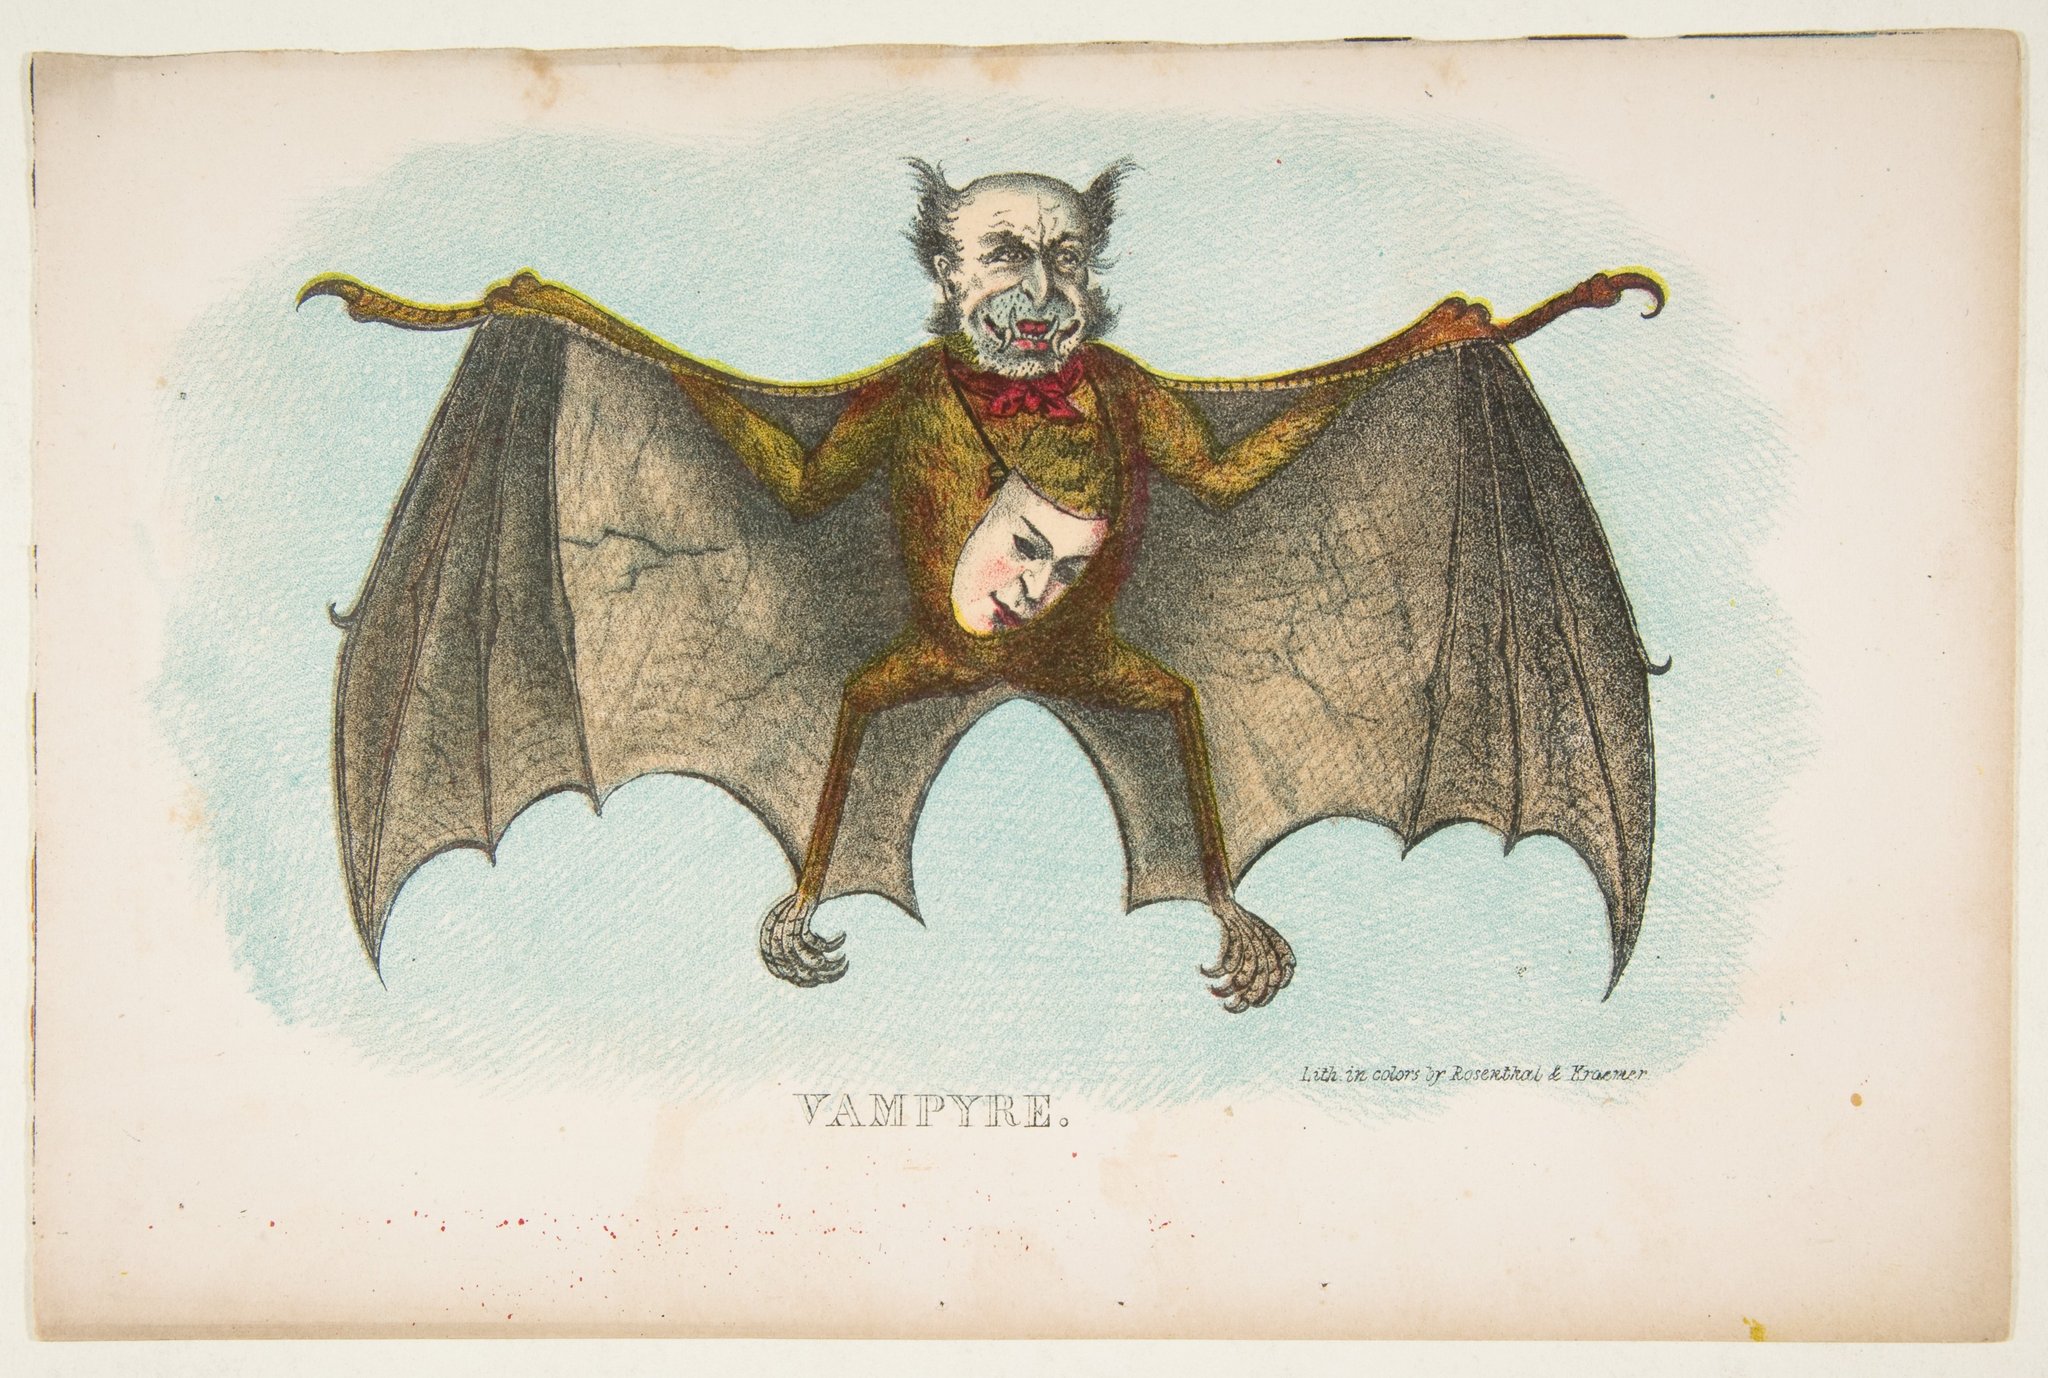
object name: print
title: Vampyr, from "The Comic Natural History of the Human Race"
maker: henry louis stephens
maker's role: artist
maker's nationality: american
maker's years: 1824-1882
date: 1851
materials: watercolor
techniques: lithograph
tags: satire